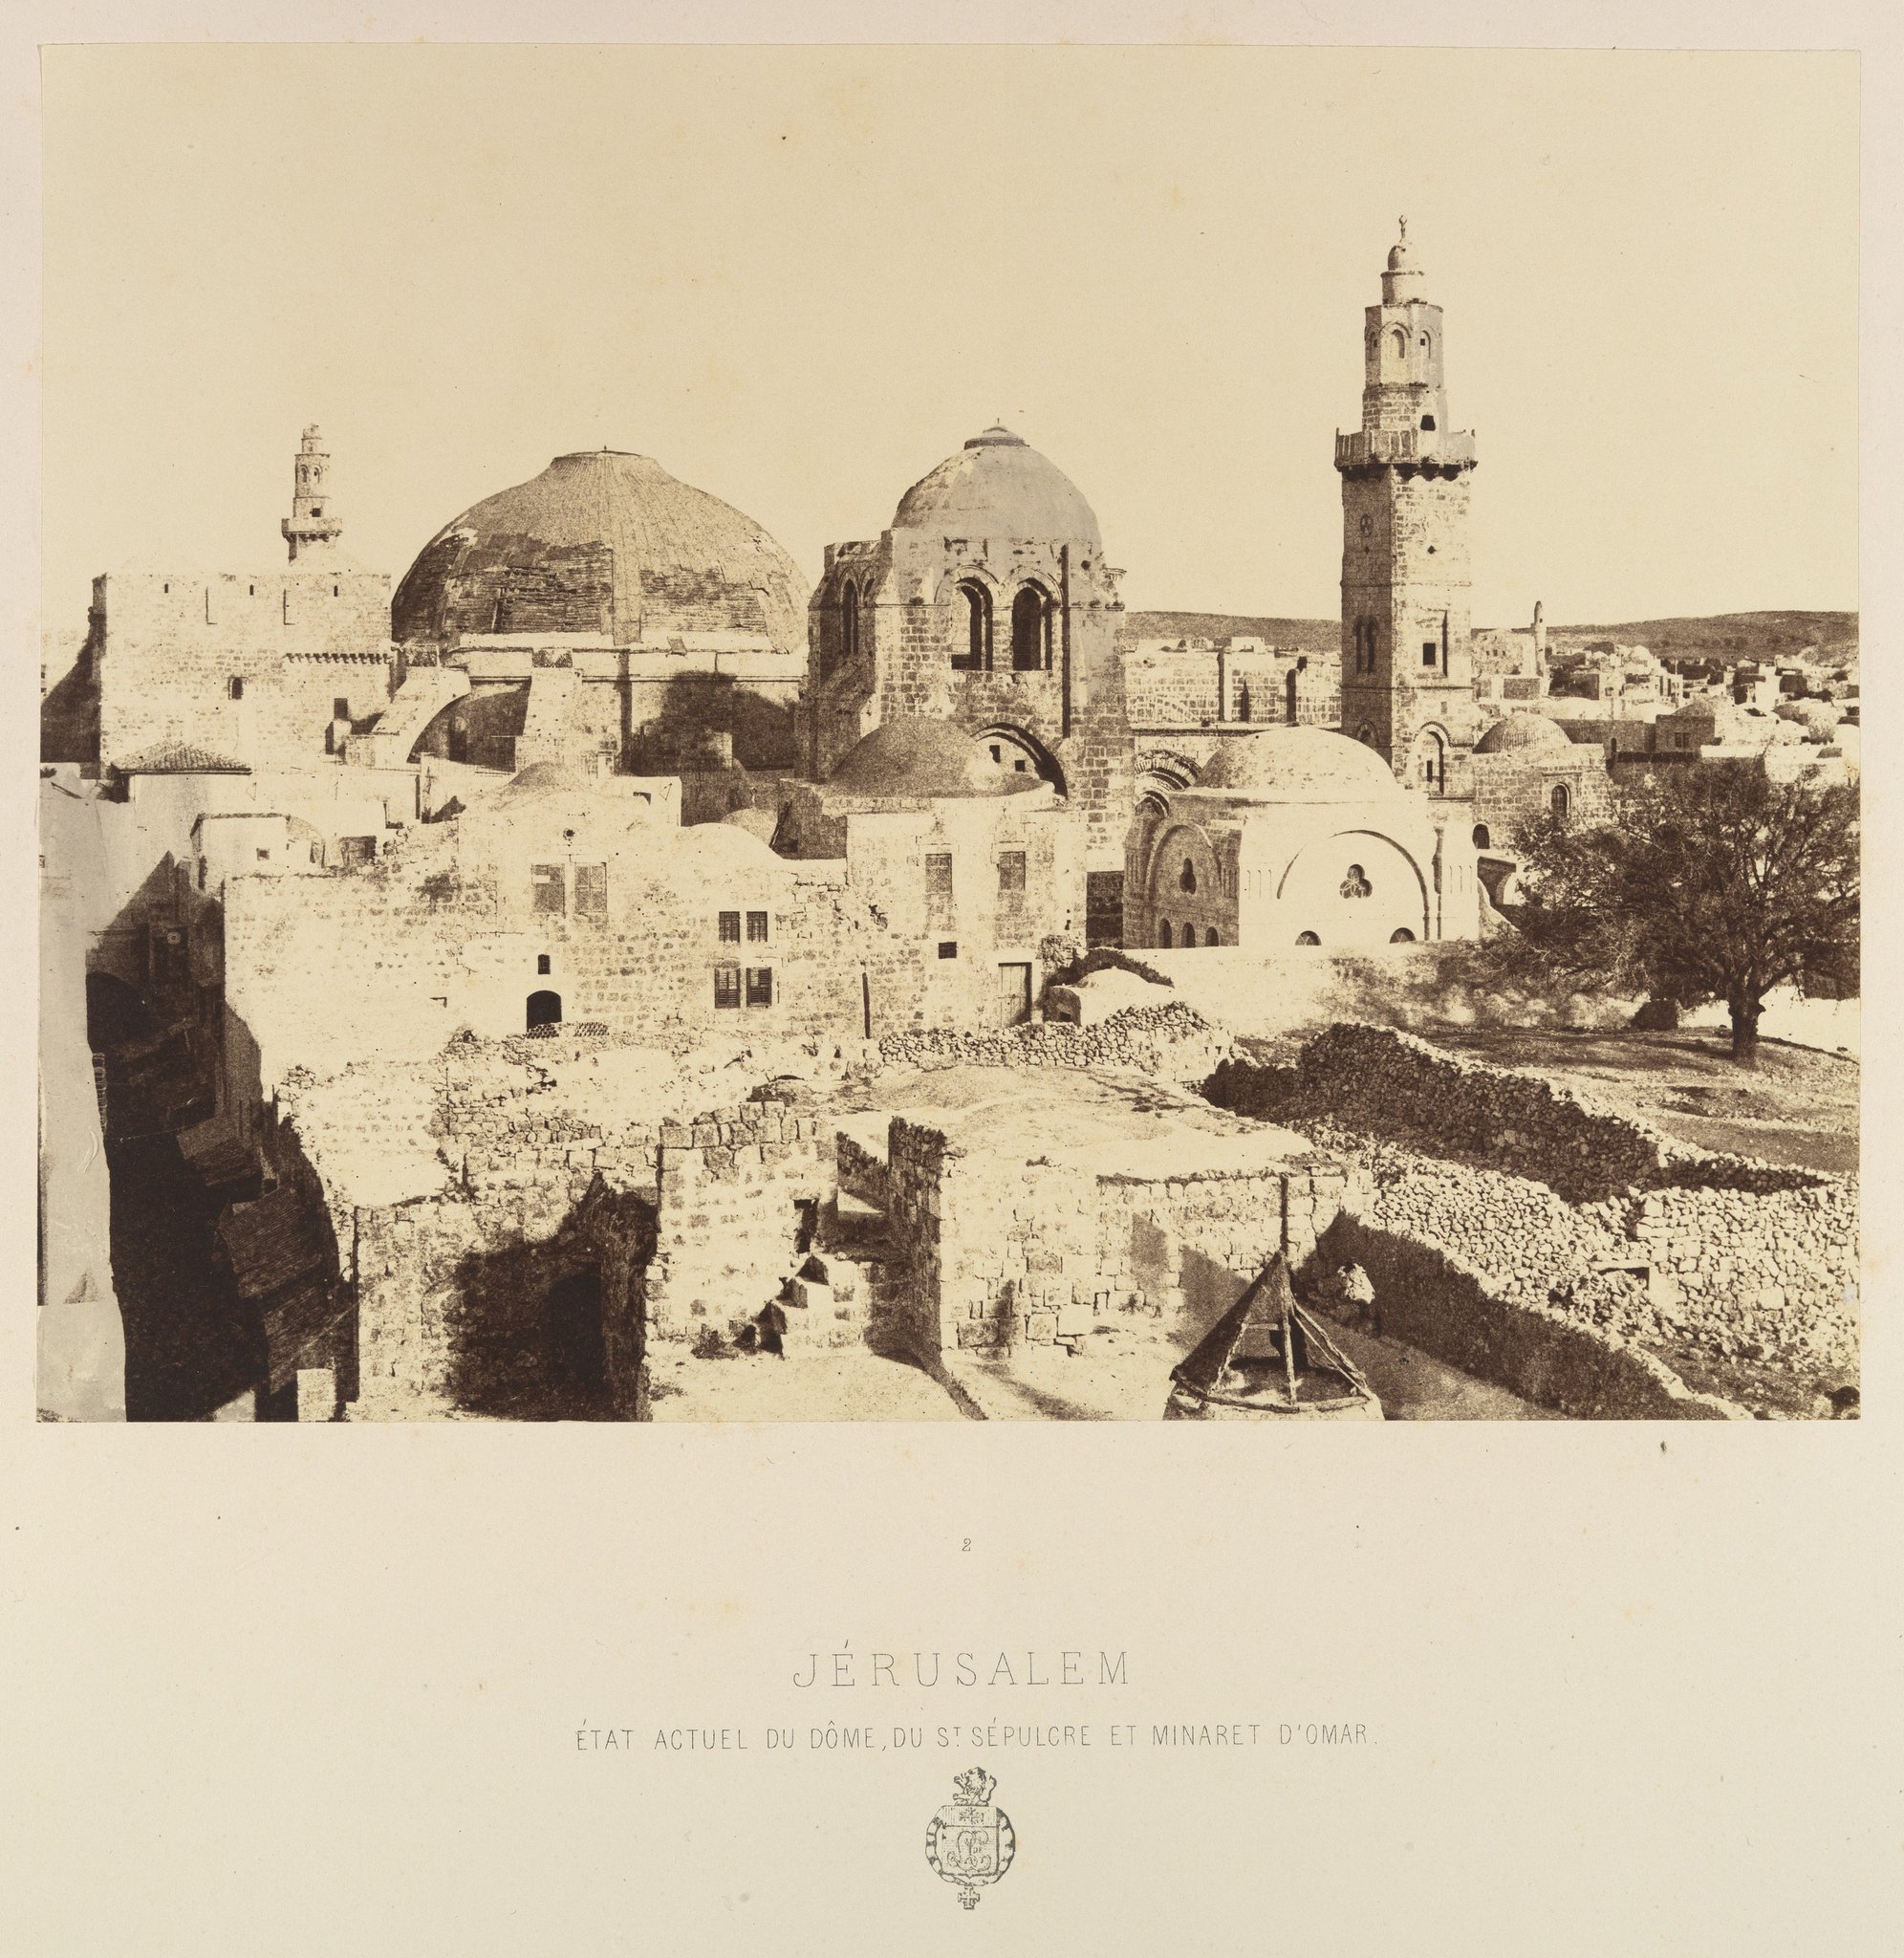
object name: photograph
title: Jérusalem. État actuel du dôme, du St. Sépulcre et Minaret d'Omar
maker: louis de clercq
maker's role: artist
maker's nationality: french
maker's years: 1837-1901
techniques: albumen silver print, paper negative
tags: architecture